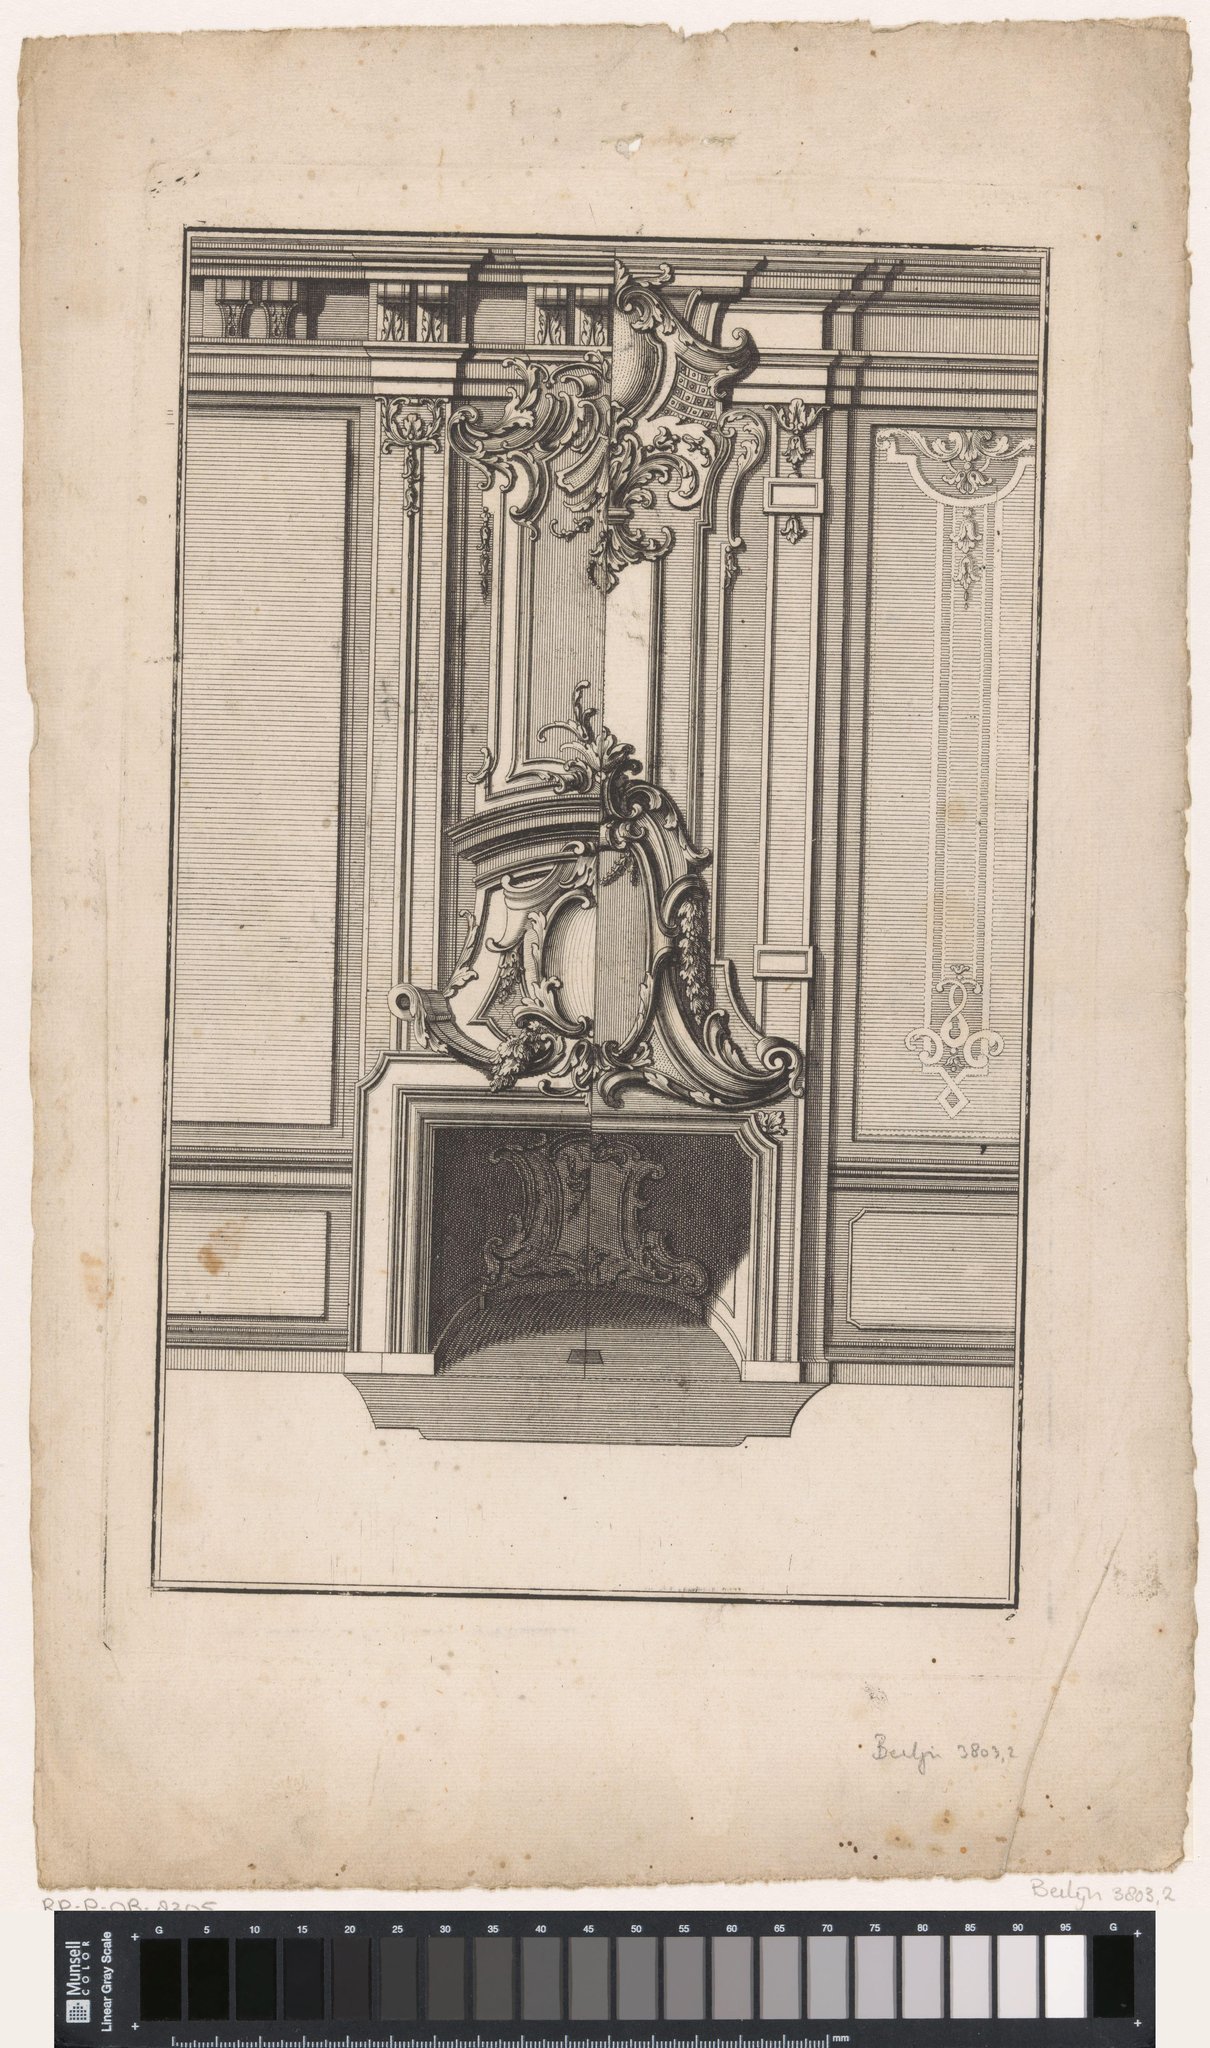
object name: ornament print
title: Geornamenteerde schouw met cartouches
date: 1726-1741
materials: paper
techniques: engraving, etching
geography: nuremberg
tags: rocaille ornament, open hearth, fire-place, ornament ~ cartouche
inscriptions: collector's mark: Lugt 2228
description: Prent uit: Schübler, Johann Jakob. Second Livre de nouveaux Cheminées (...). [Neurenberg]: Weigel, weduwe Johann Christoph, [na 1726].